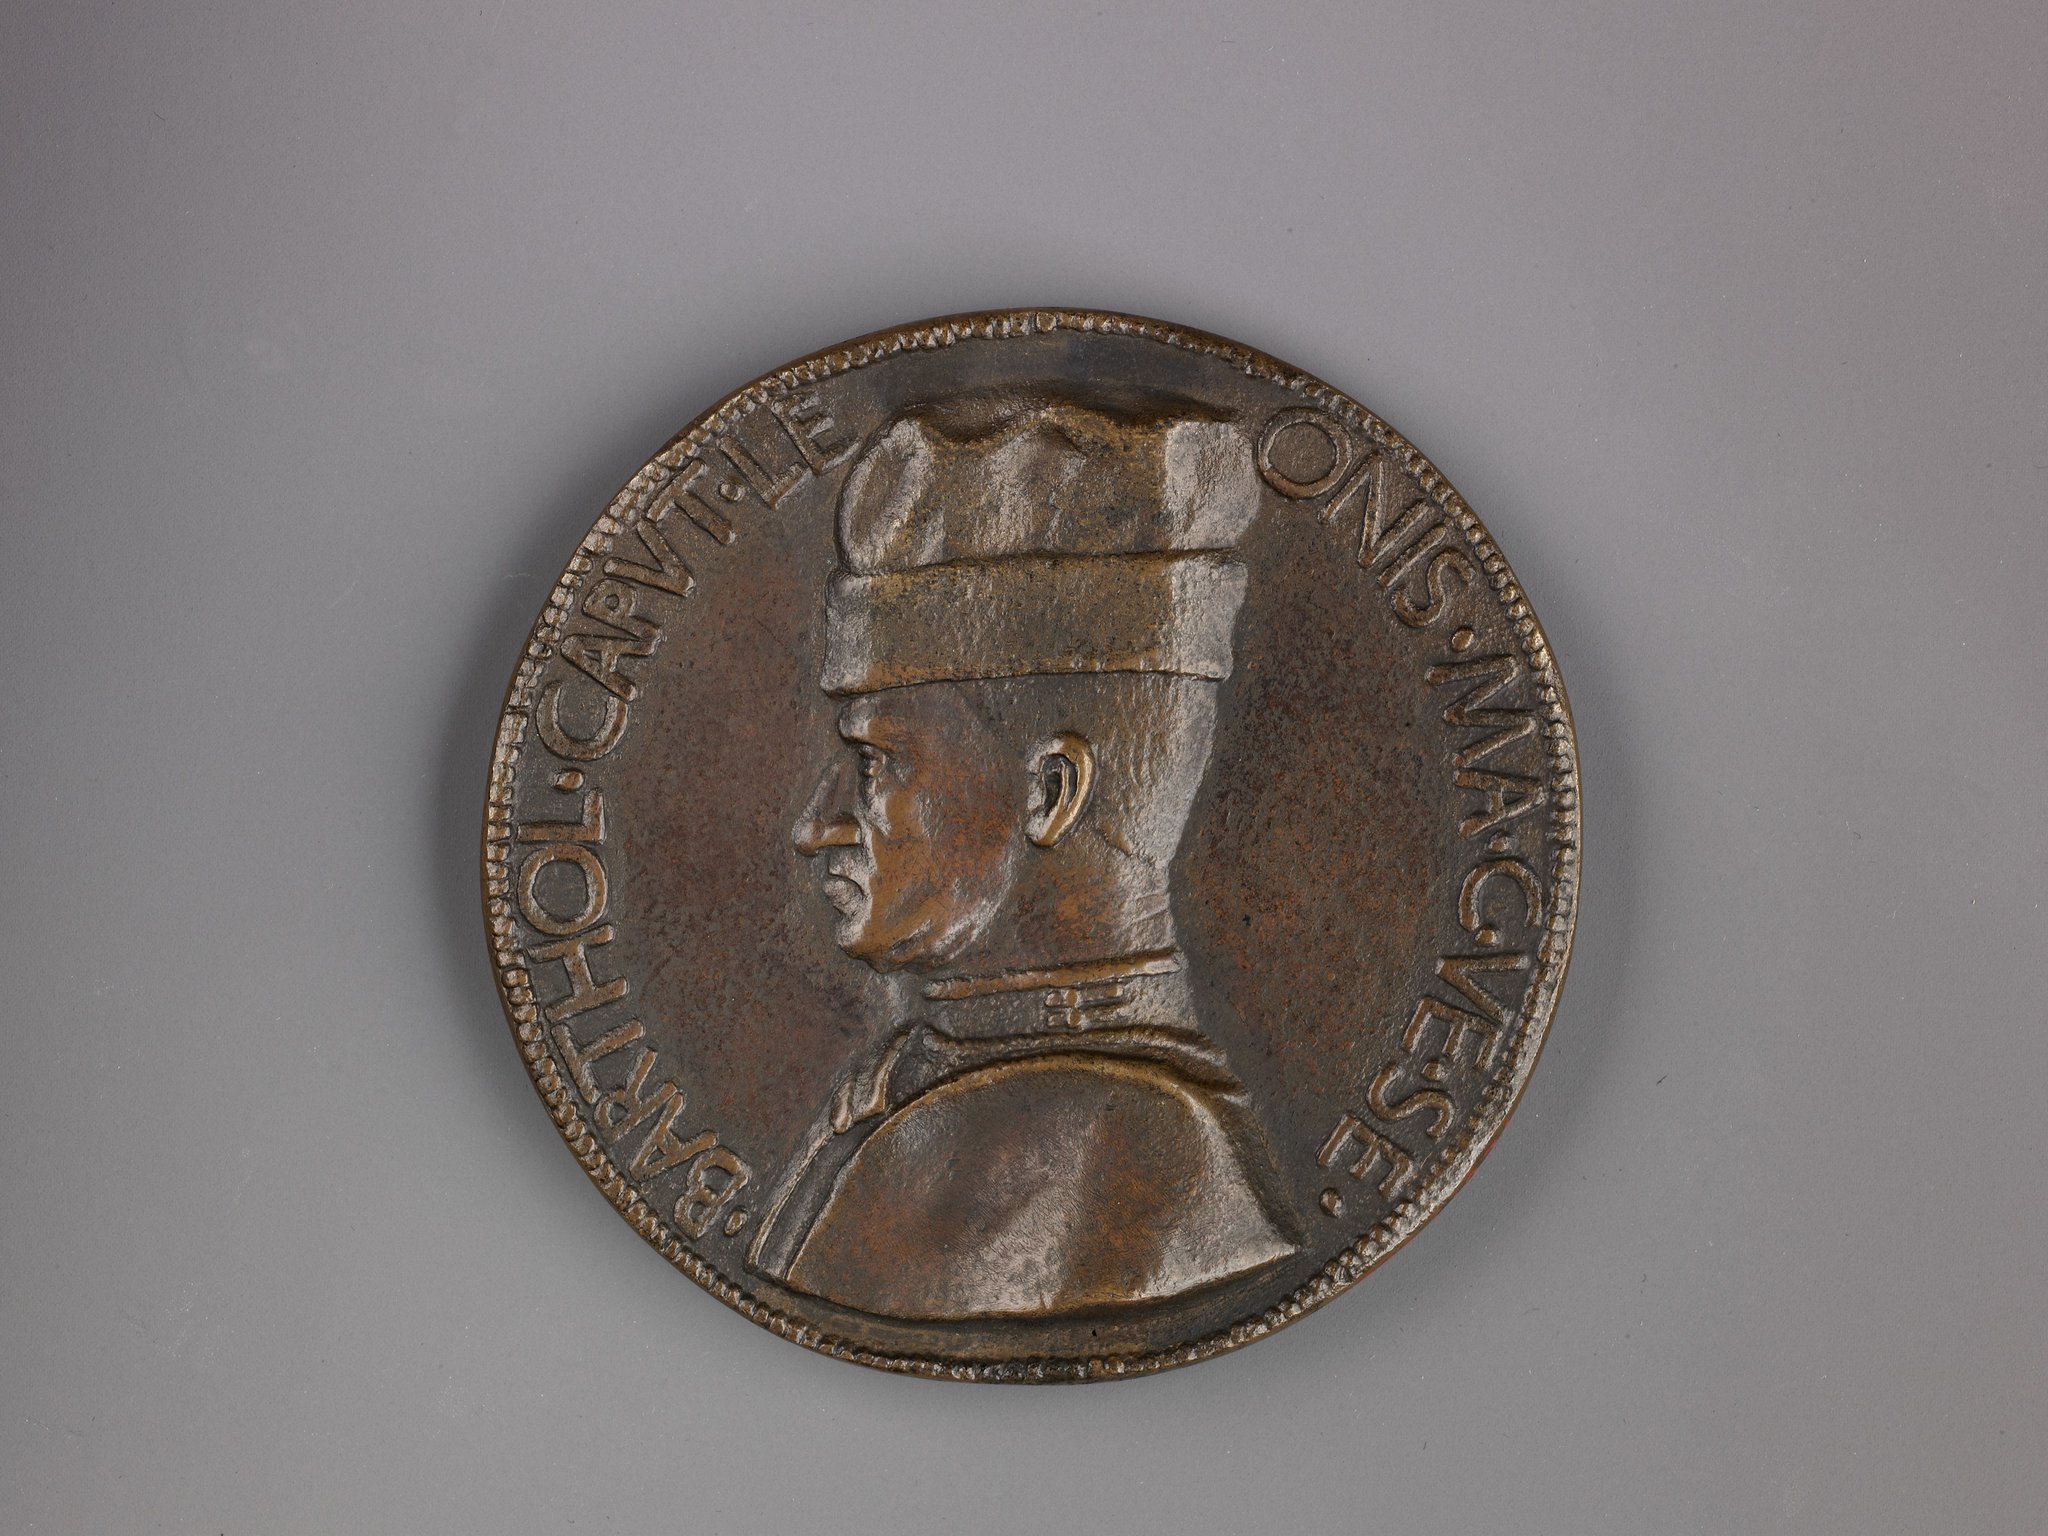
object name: medal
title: Medal: Bartolomeo Colleoni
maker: marco guidizani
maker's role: artist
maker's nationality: italian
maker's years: 1454-1462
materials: bronze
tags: men,portraits,profiles